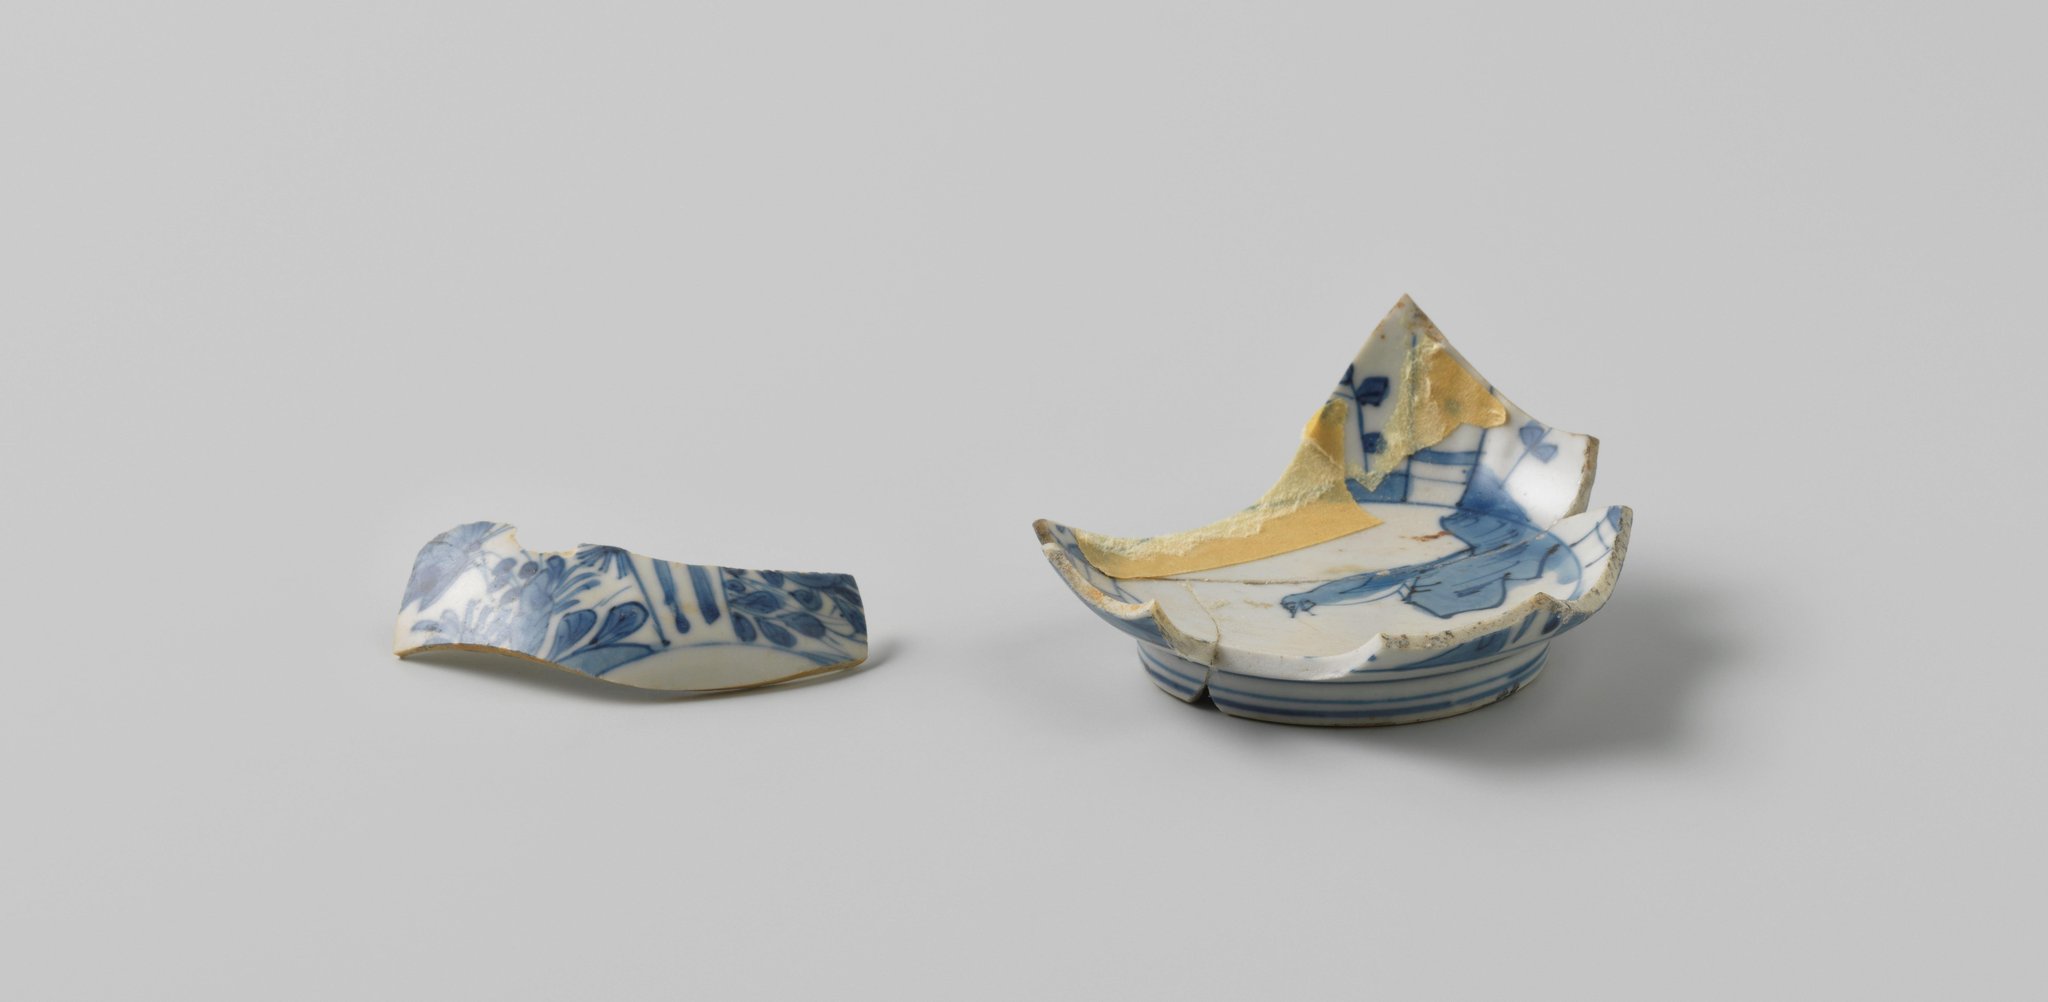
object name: bowl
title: Scherven van een kraaikop uit V.O.C.-schip de 'Witte Leeuw'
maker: Anonymous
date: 1613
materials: bone china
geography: jingdezhen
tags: verenigde oostindische compagnie, sint-helena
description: Scherven van een kraaikop uit V.O.C.-schip de 'Witte Leeuw'.